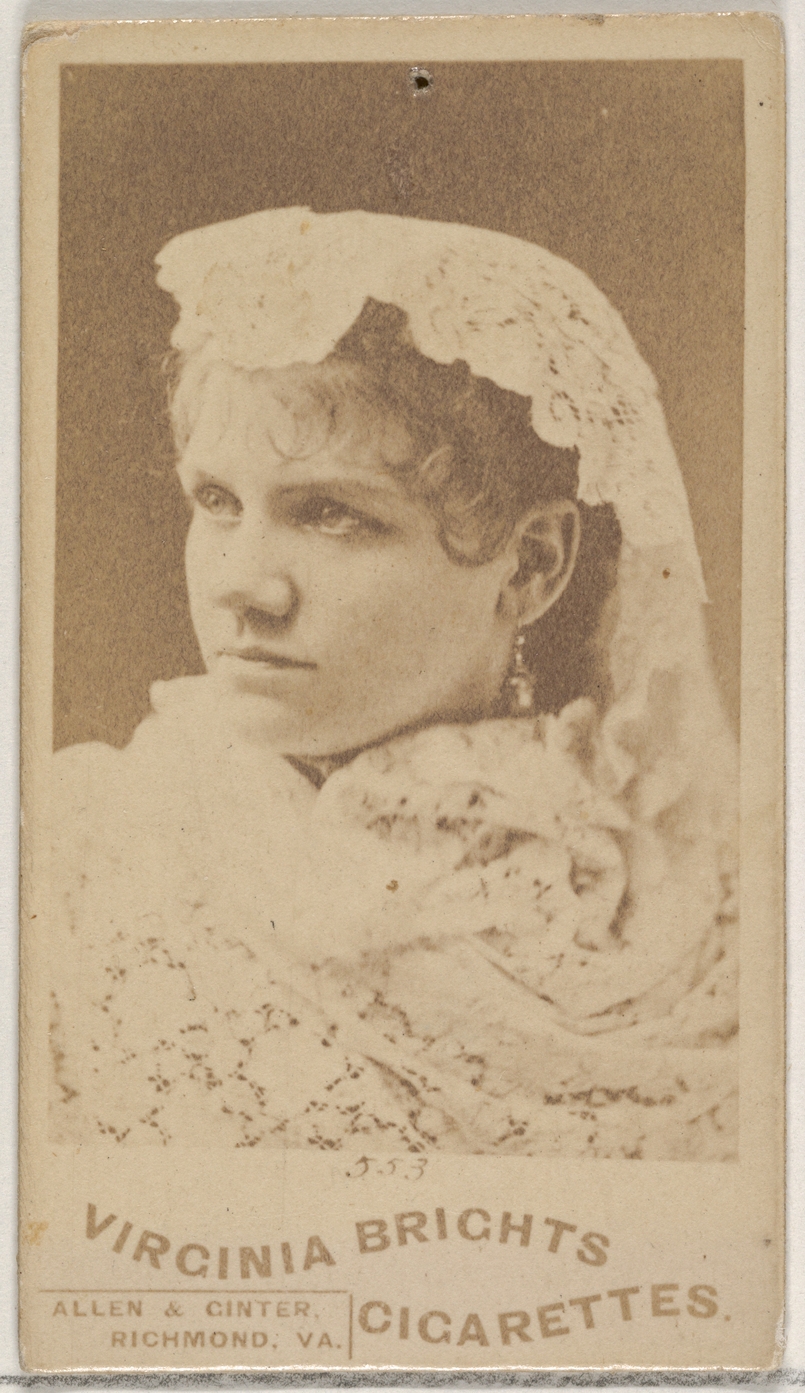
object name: photograph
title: From the Actors and Actresses series (N45, Type 5) for Virginia Brights Cigarettes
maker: allen & ginter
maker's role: publisher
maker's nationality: american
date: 1888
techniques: albumen silver print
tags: portraits,women,actresses